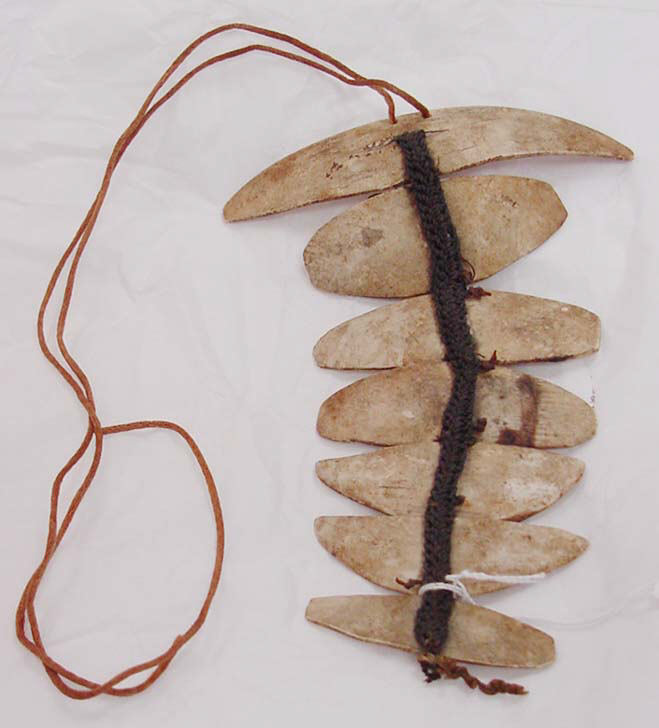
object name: necklace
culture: oceanic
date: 1801-1900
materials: bone, silk, fiber